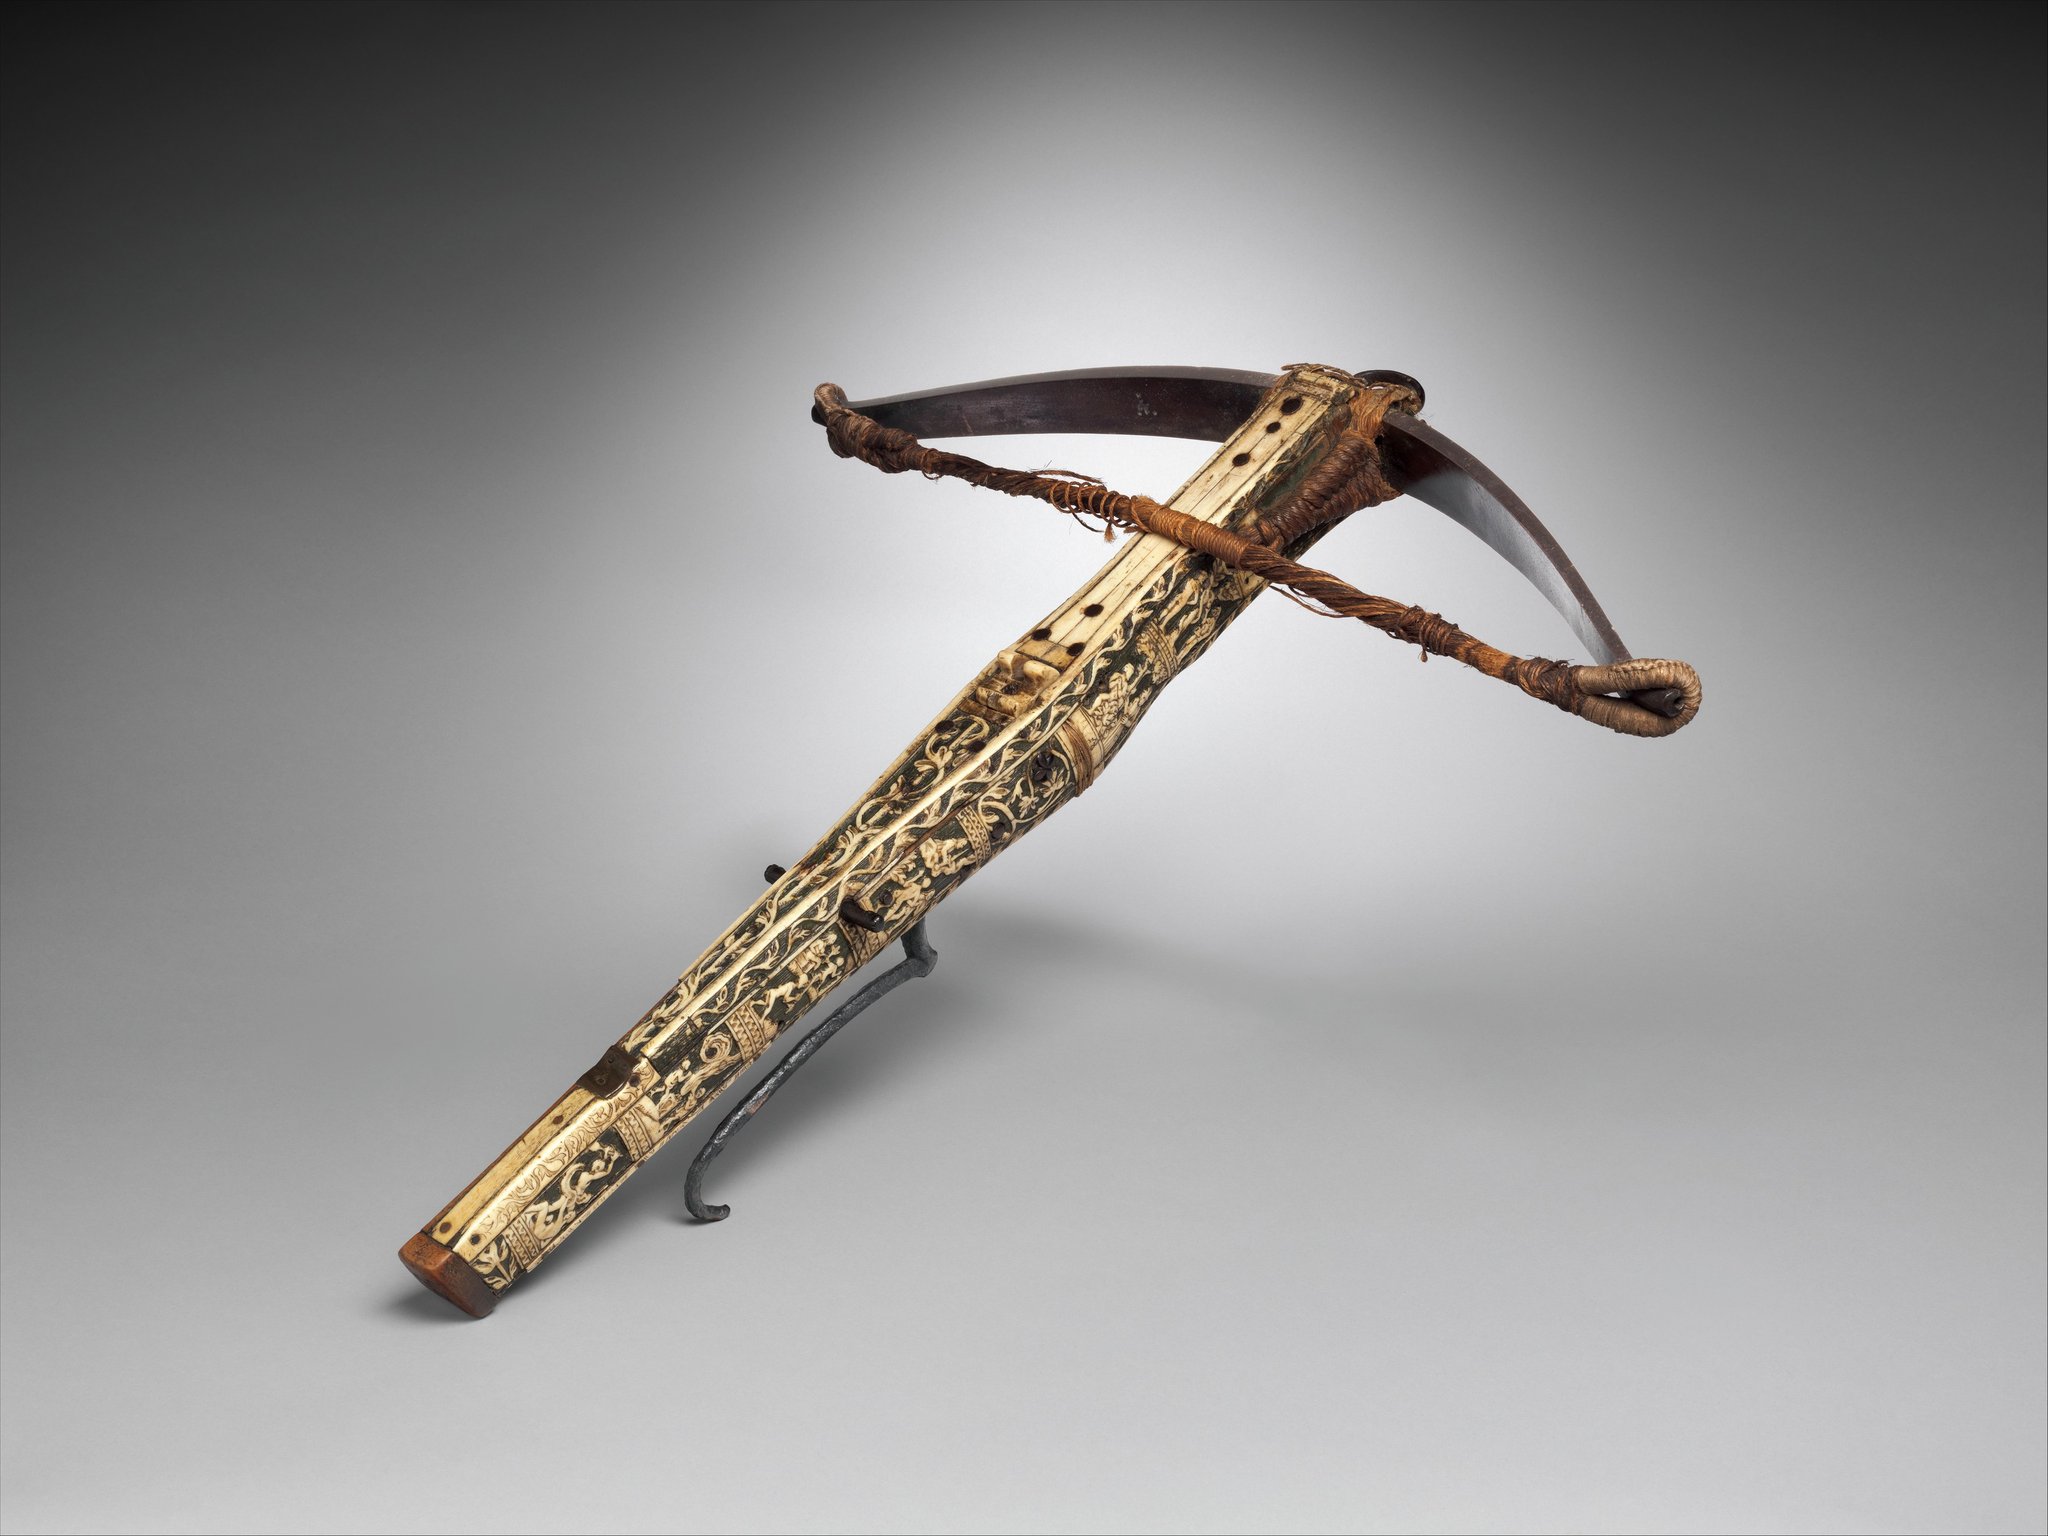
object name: crossbow with cranequin winder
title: Crossbow (Halbe Rüstung) with Cranequin (Winder)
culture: crossbow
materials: copper alloy, hemp, leather, steel, wood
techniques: polychromy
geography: germany